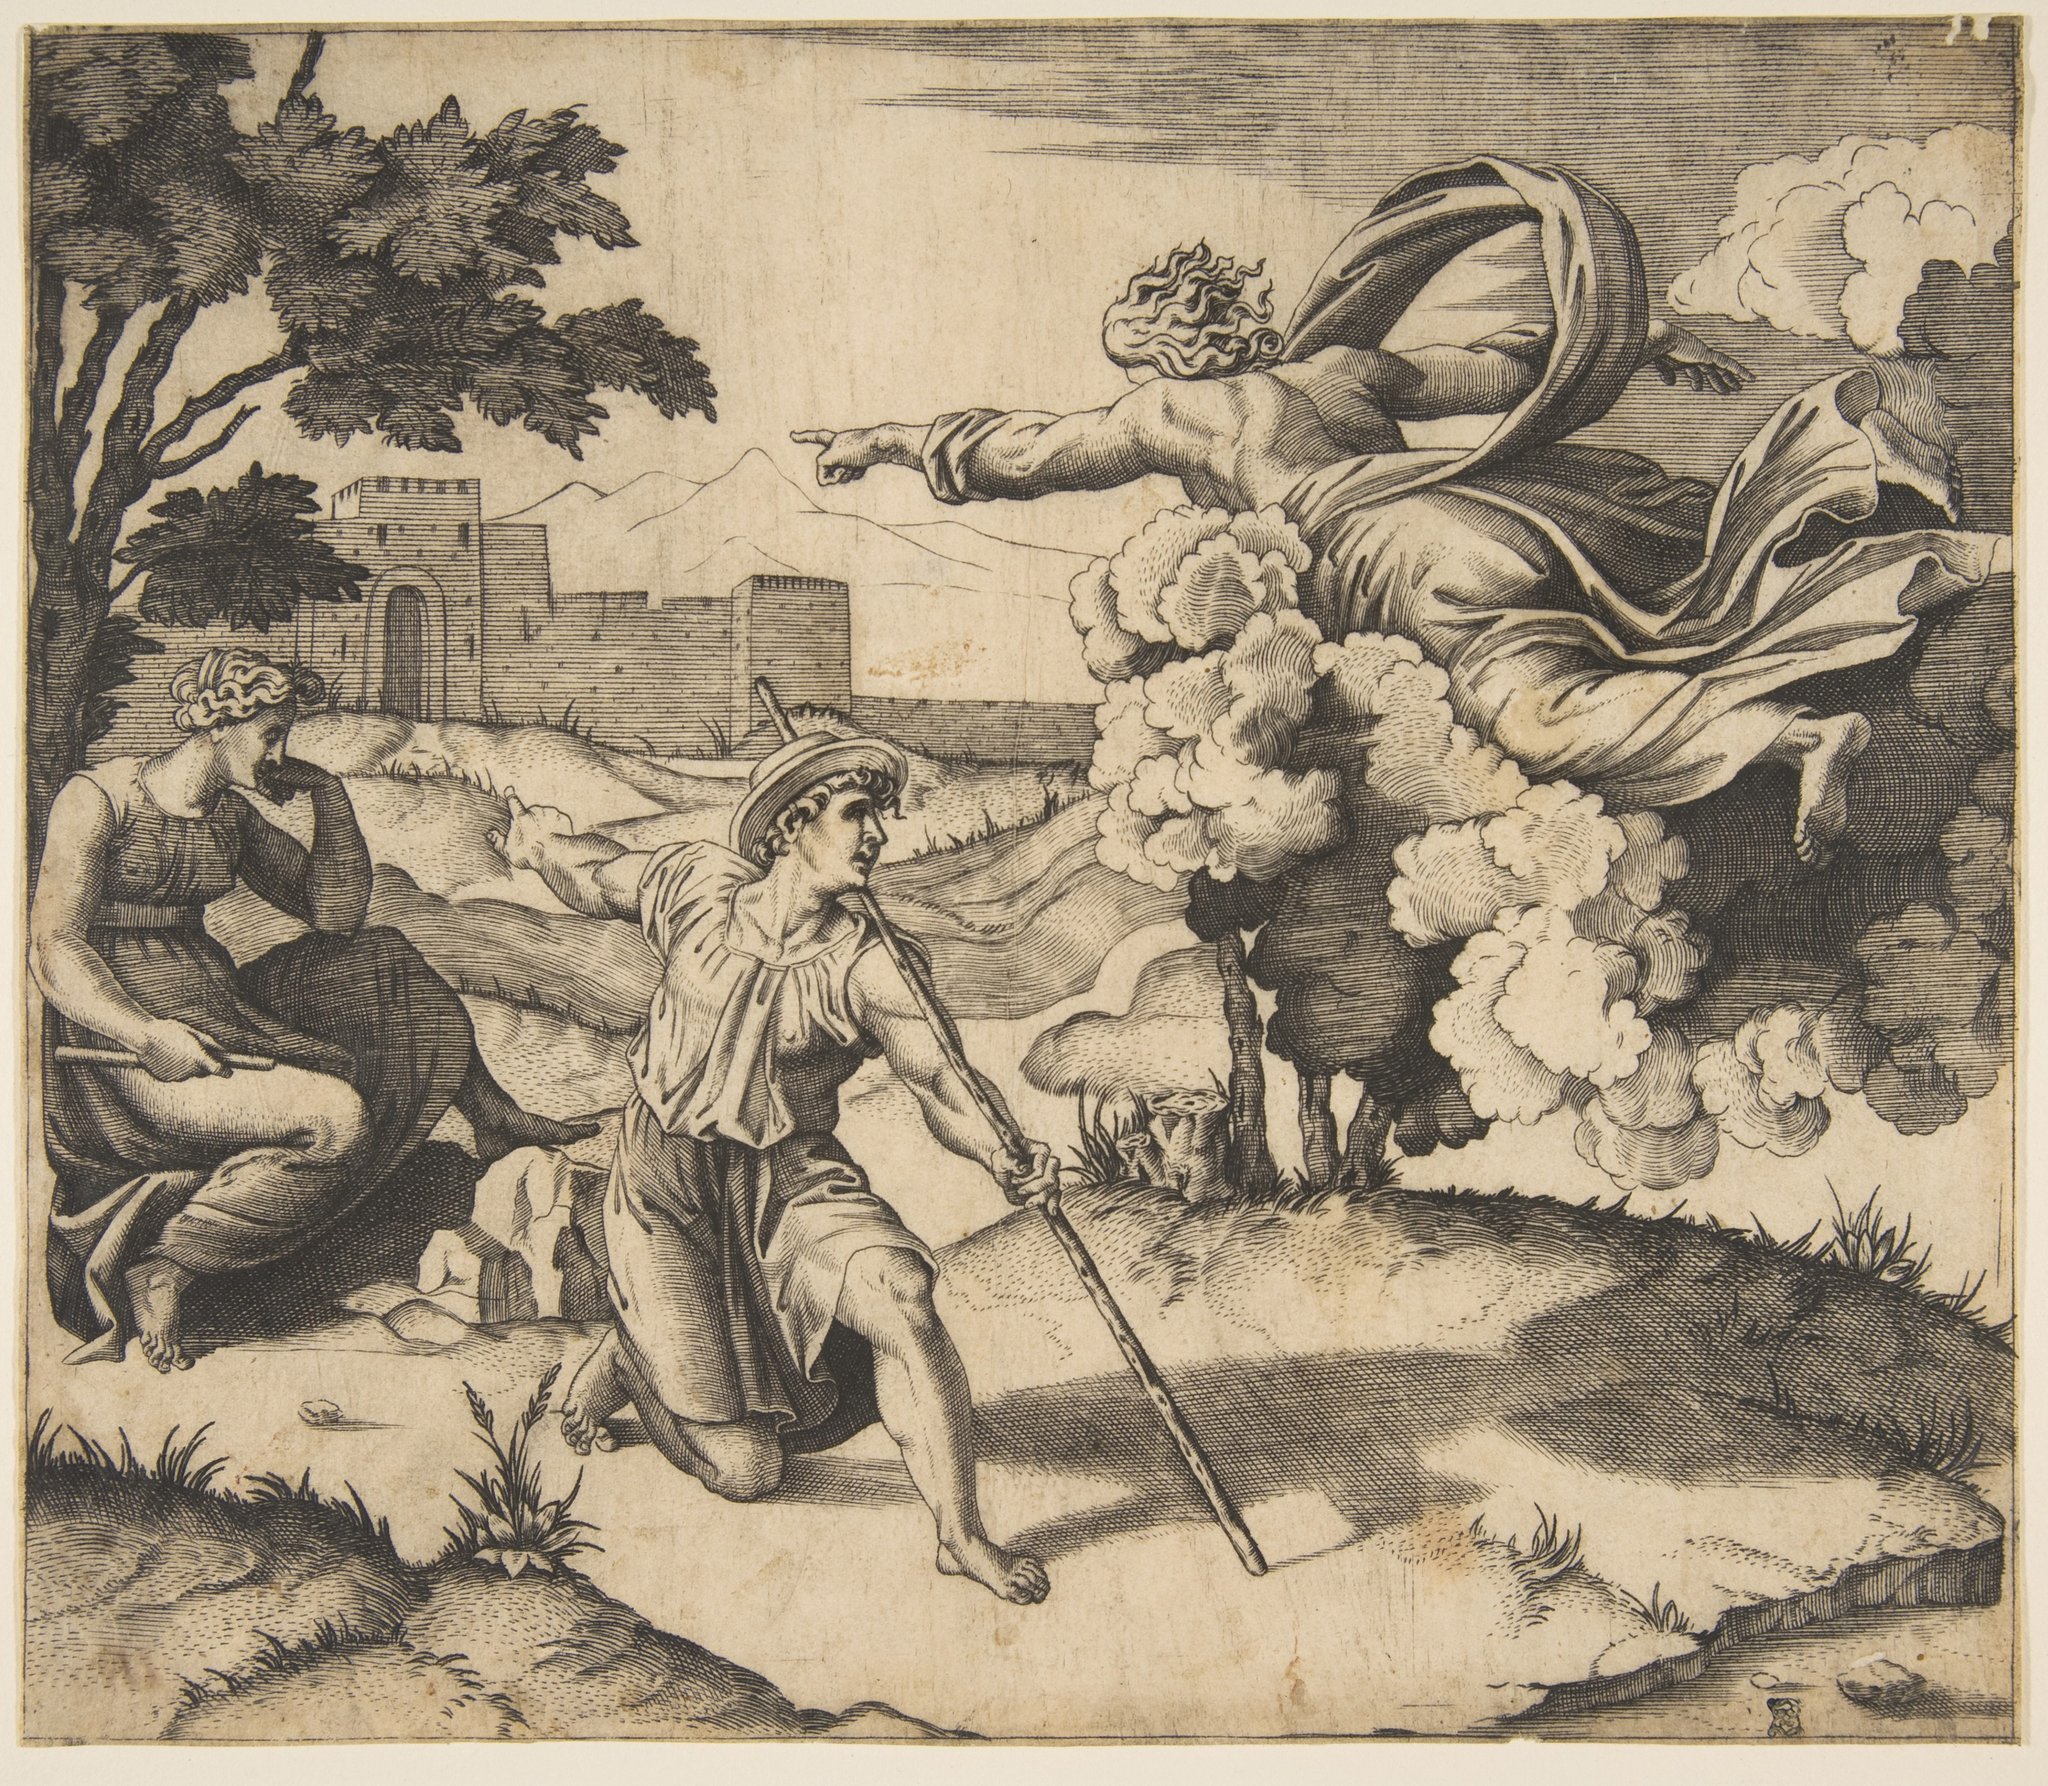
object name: print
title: God appearing to Isaac; God floating in clouds pointing toward Rebecca seated under a tree at left, Isaac kneeling in the center holding a large stick and also pointing to Rebecca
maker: marco dente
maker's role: artist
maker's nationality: italian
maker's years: 1515-1527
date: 1515-1527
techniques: engraving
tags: men,women,isaac,god the father